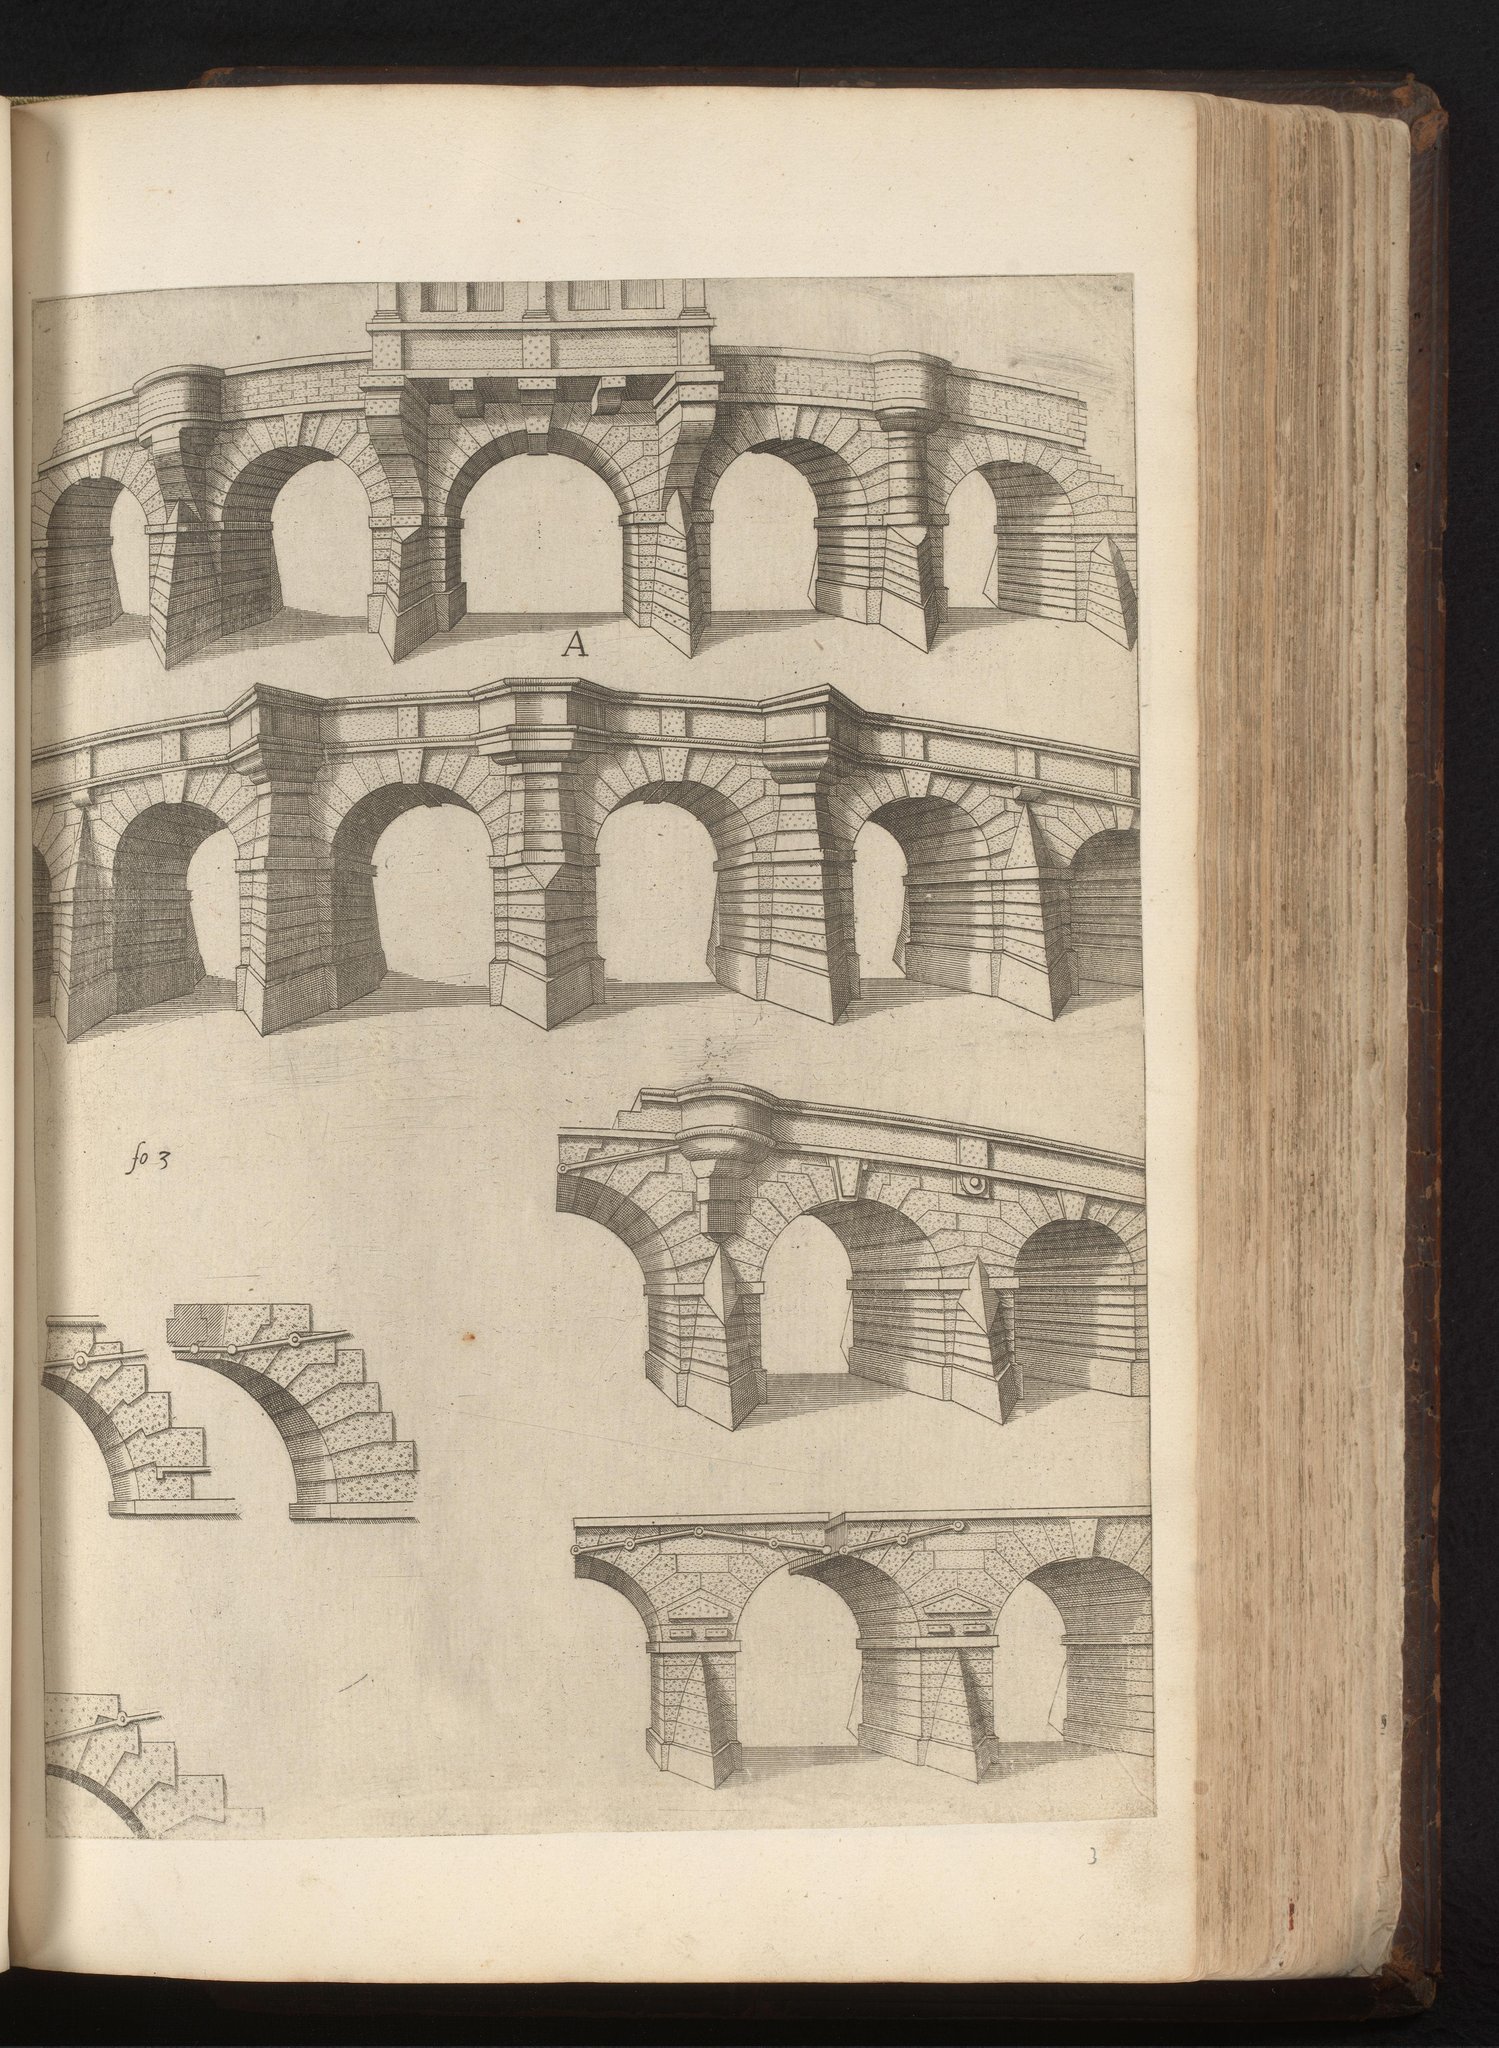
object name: print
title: Bruggen in de Toscaanse orde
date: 1581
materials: paper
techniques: engraving, etching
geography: antwerp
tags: tuscan order ~ architecture, bridge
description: Prent uit: Vredeman de Vries, Hans. Architectura oder Bauung der Antiquen auss dem Vitruvius, waellches sein funff Collummen orden, (...). Antwerpen: Gerard de Jode en Gerard Smits, 1581. Prent eerder verschenen in de 1577-editie.